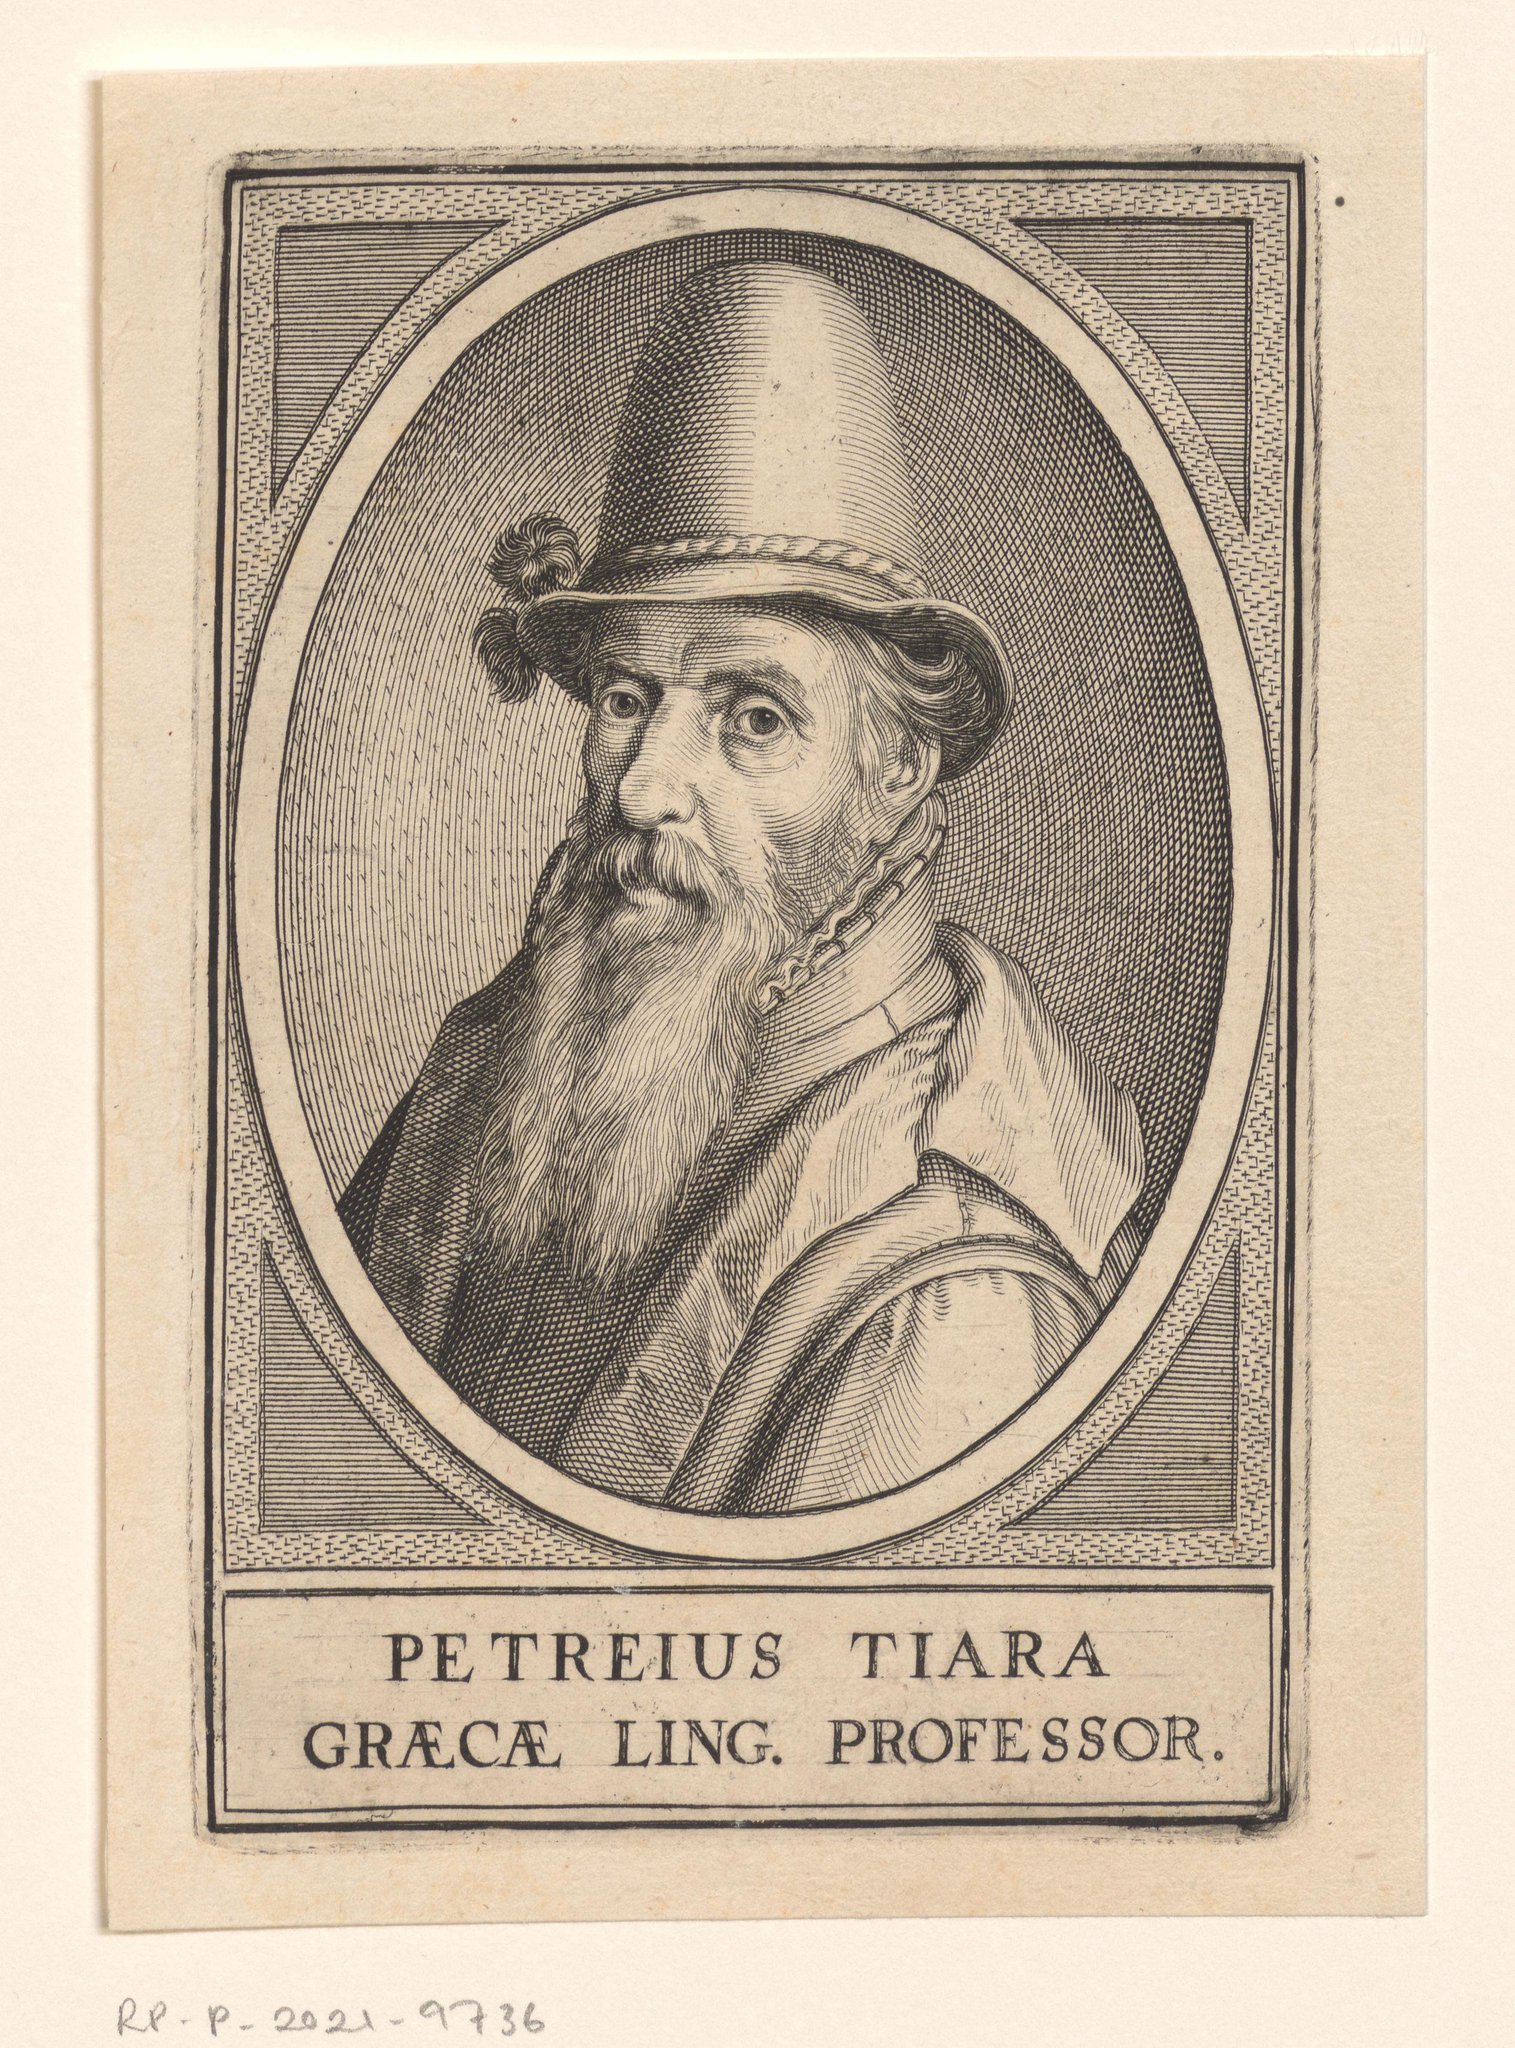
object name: print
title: Icones ad vivum delineatae et expressae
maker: willem isaacsz. van swanenburg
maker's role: print maker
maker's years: 1580-1612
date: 1609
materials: paper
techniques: engraving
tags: historical persons, professor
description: Prent mogelijk uit: Icones ad vivum delineatae et expressae. Leiden: Andries Clouck, 1609. Prent kan ook afkomstig zijn uit de prentserie: Les vrays pourtraits de les celebres et plus renommés professeurs depuis le commencement de l'Illustre Academie de Leide. S.l.s.n., ca. 1715 (mogelijk uitgegeven door Pieter van der Aa in Leiden). Prent met tekst op verso gebruikt in: Meursius, Joannes. Illustris academia Lugd-Batava (...). Leiden: Andries Clouck, 1613; Meursius, Joannes. Icones, elogia ac vitae professorum Lugdunensium apud Batavos (...). Leiden: Andries Clouck, 1617 en in: Meursius, Joannes. Athenae Batavae. Sive, de urbe Leidensi & academia, virisuw claris (...). Leiden: Andries Clouck en Bonaventura en Abraham Elzevier, 1625. Latere staat uitgegeven door Pieter van der Aa in Leiden.